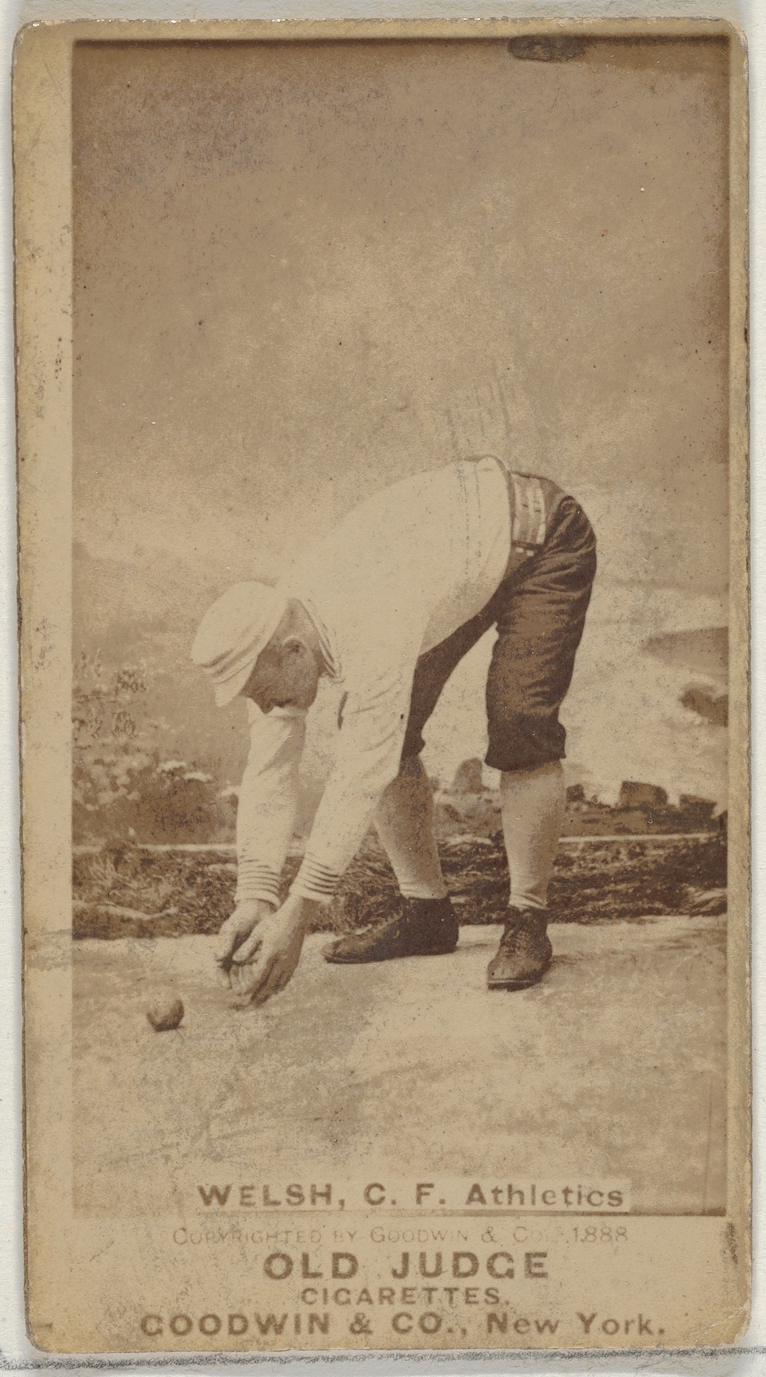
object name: baseball card, photograph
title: Welch, Center Field, Philadelphia Athletics, from the Old Judge series (N172) for Old Judge Cigarettes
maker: goodwin & company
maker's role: publisher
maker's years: 1850-1950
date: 1888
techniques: albumen silver print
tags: men,portraits,baseball,athletes